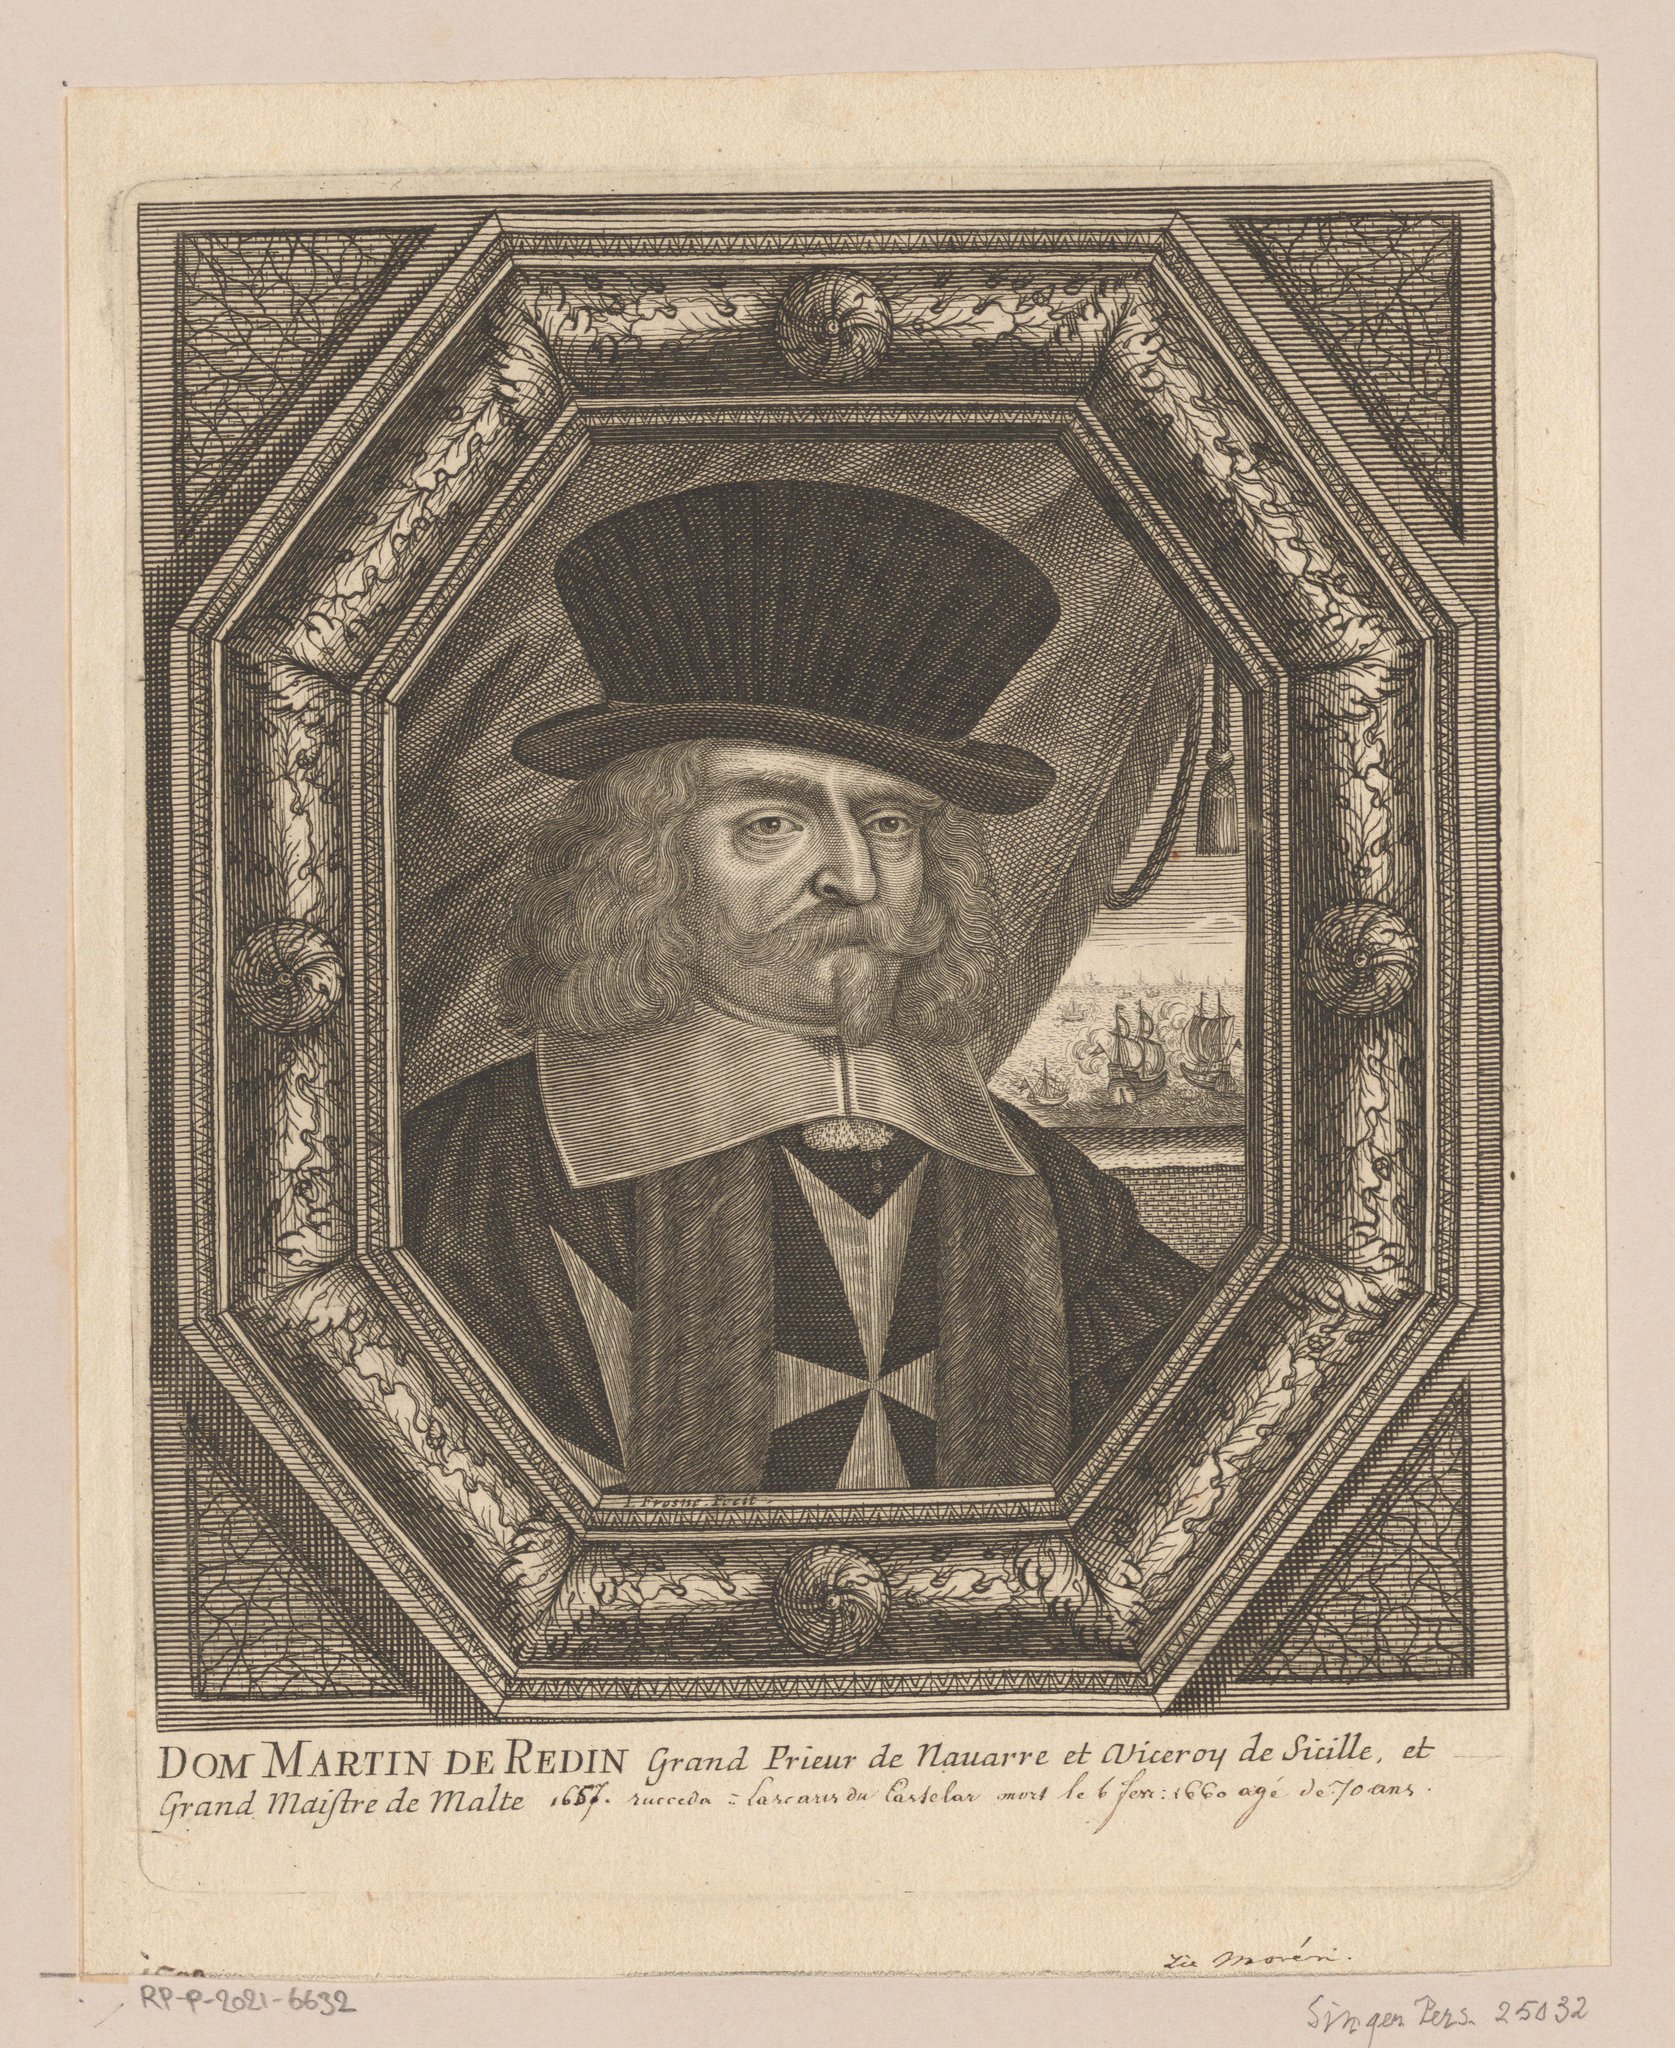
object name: print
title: Portret van Martín de Redín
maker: jean frosne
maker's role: print maker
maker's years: 1623-1676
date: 1633-1676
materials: paper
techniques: engraving, etching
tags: politician, historical persons, warfare; military affairs (+ naval force)